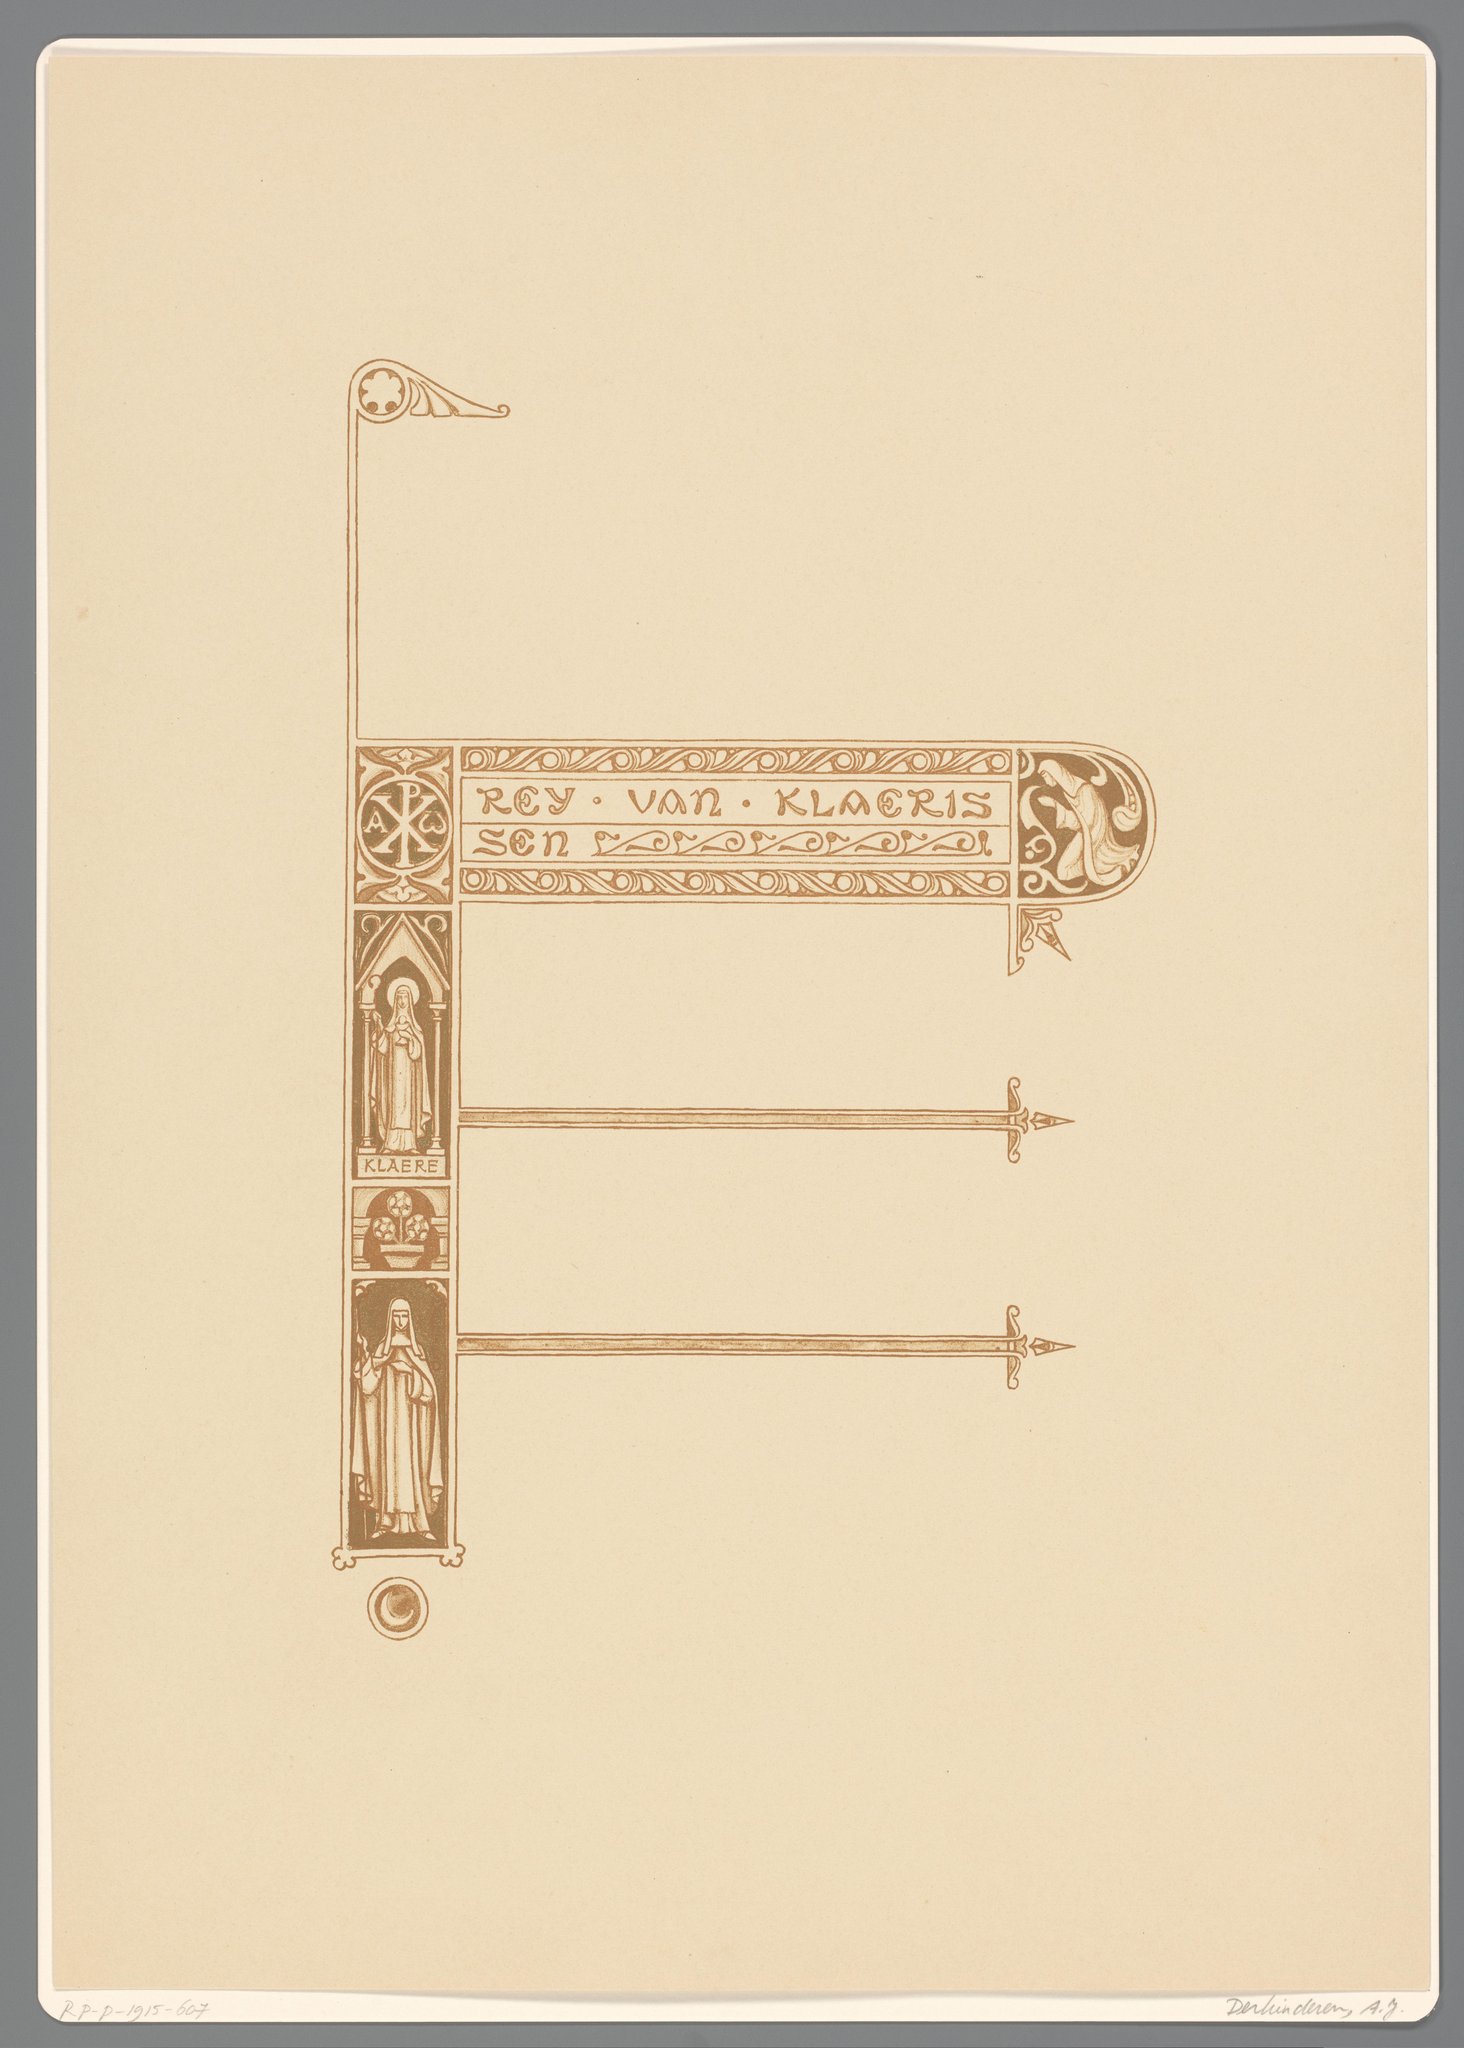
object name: print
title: Rey van klaerissen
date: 1894-1901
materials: paper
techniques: lithograph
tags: nun(s)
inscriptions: collector's mark: Lugt 2233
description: Een horizontale, decoratieve titelband waarin de rei van clarissen wordt aangekondigd. Links van de titelband een verticale sierrand met daarin de beeltenissen van twee clarissen.